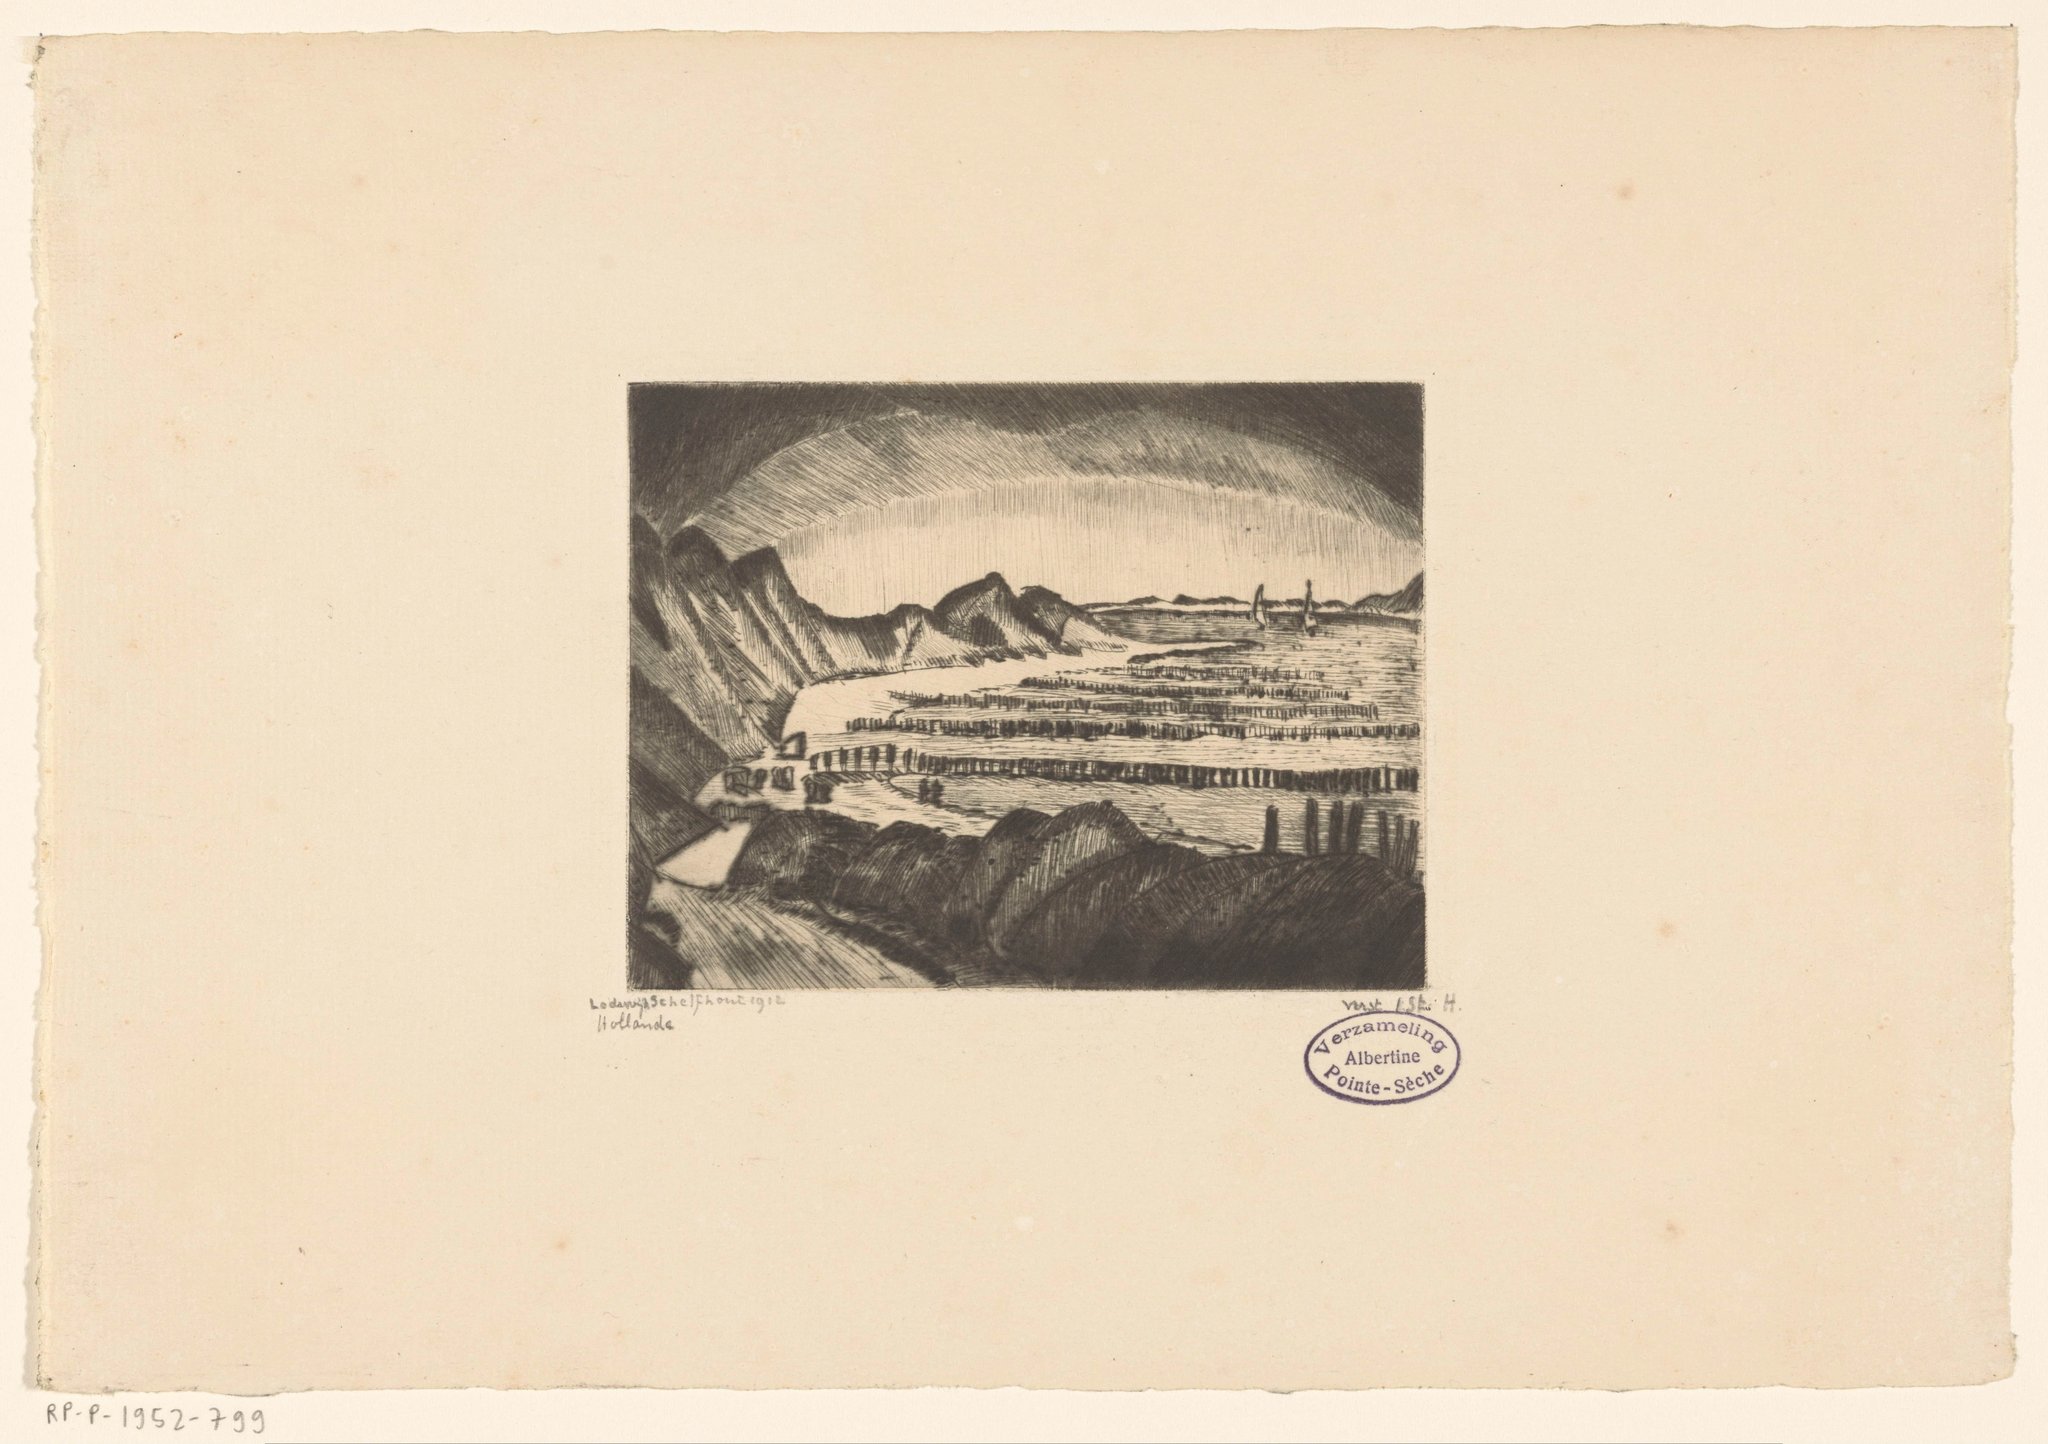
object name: print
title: Strand van Domburg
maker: lodewijk schelfhout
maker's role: draughtsman, print maker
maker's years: 1881-1943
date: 1912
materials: paper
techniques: drypoint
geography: paris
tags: beach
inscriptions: collector's mark: Lugt 5i, collector's mark: Lugt 2760, collector's mark: Lugt 2228